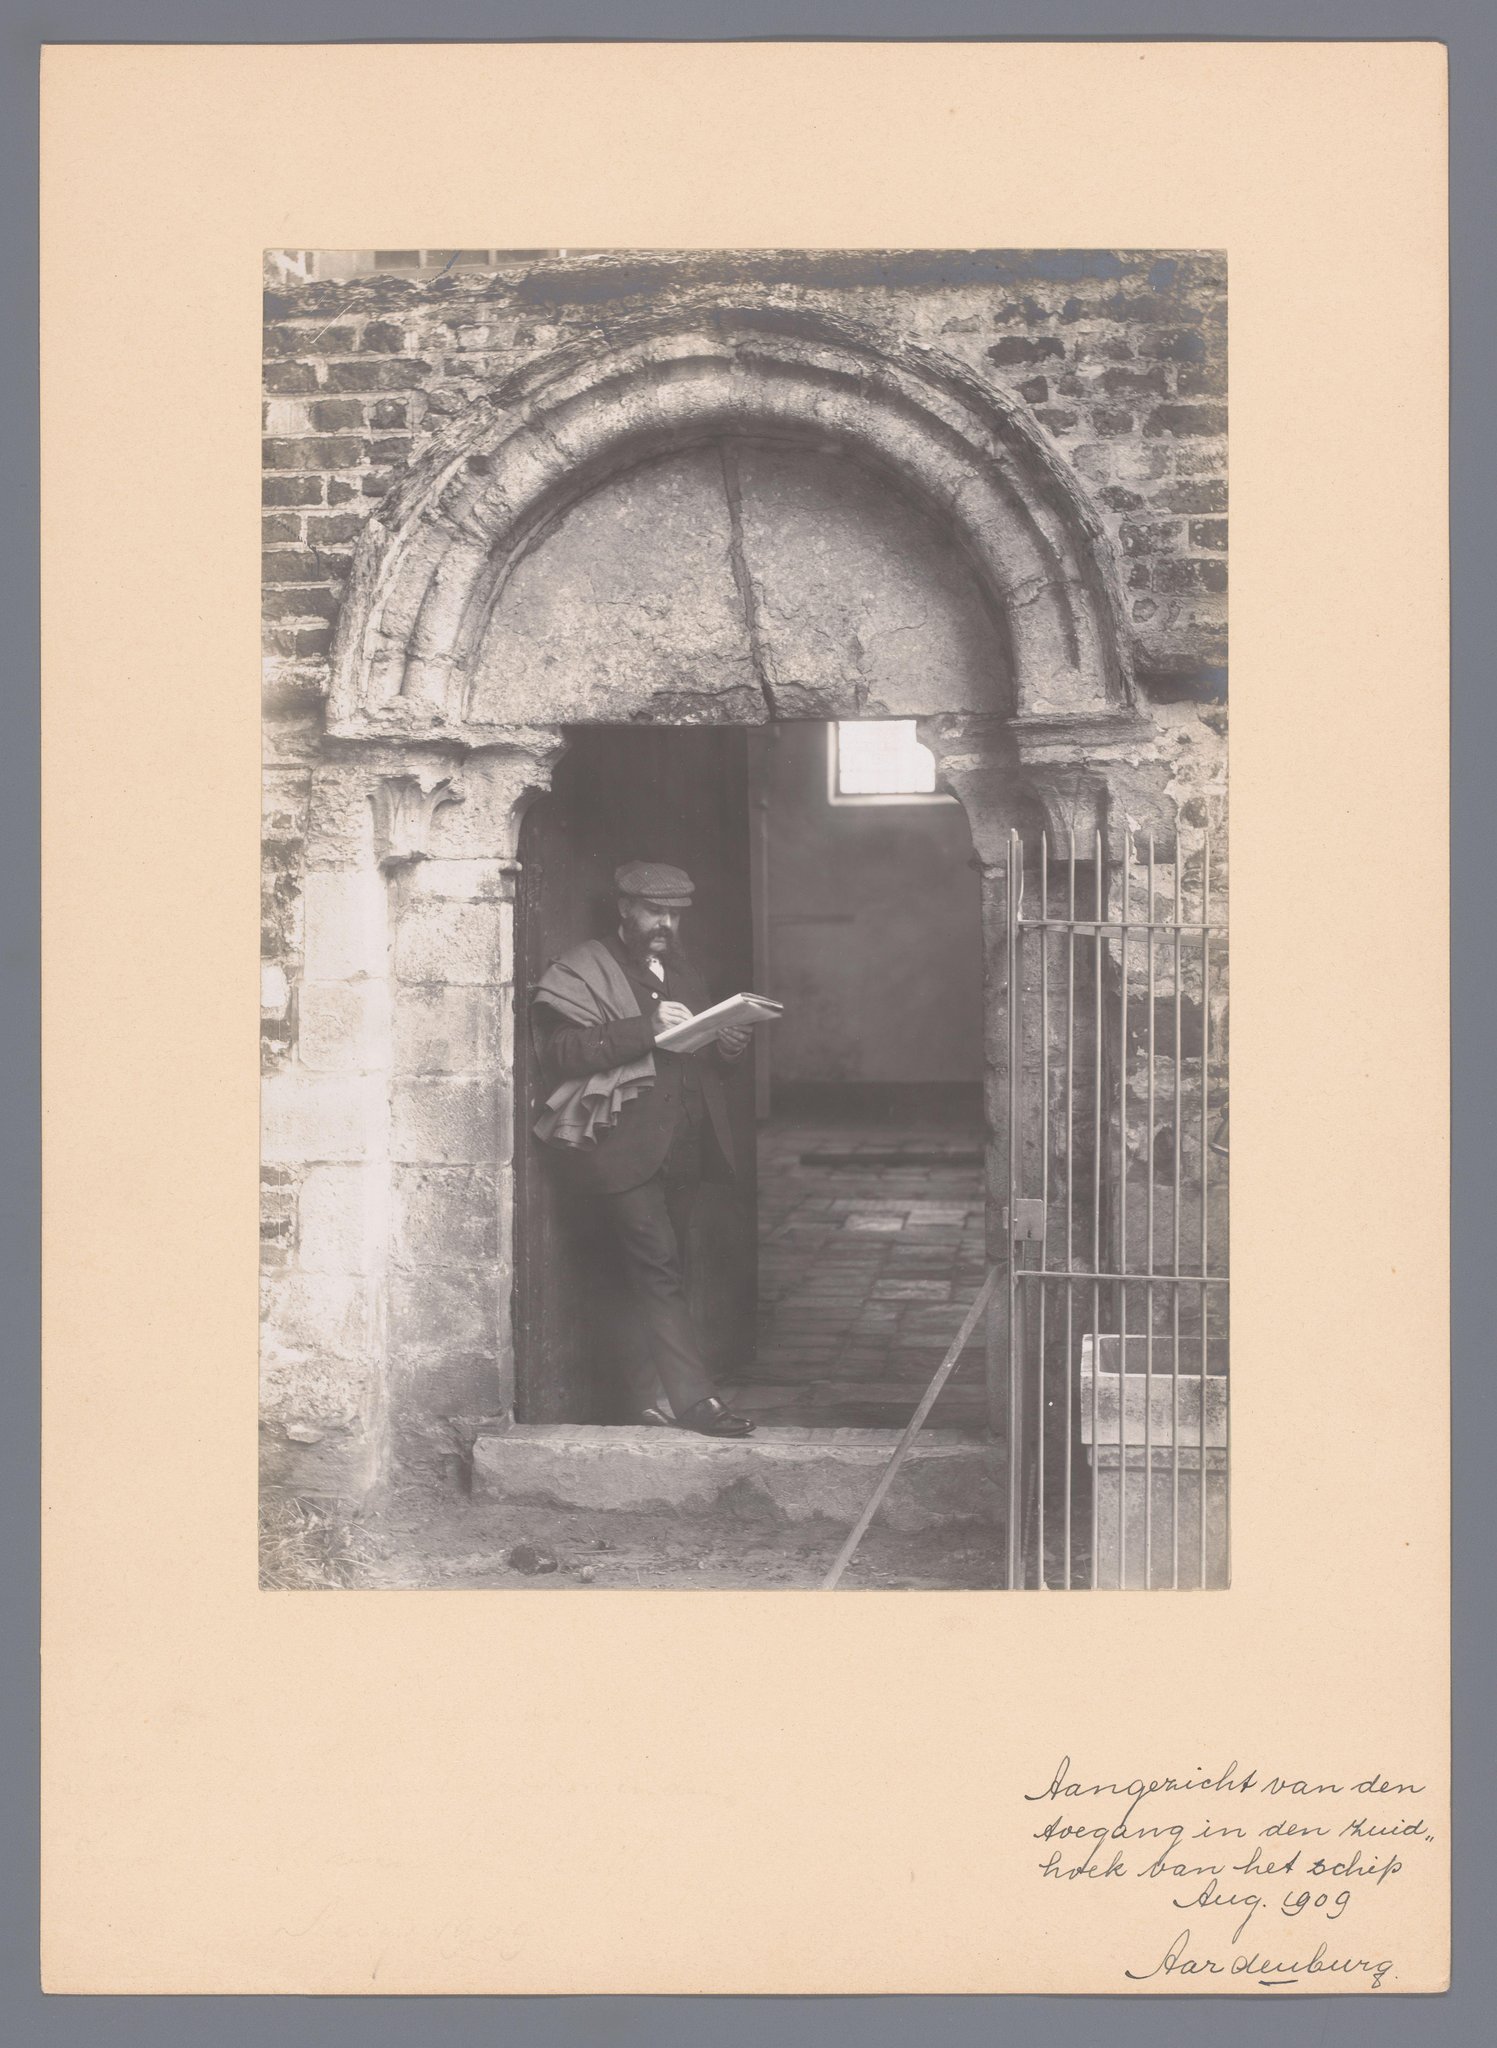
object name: photograph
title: A.J.M. Mulder staand in de toegang van het schip van Nederlands-Hervormde kerk in Aardenburg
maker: a.j.m. mulder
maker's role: engineer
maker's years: 1856-1936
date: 1909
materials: cardboard, photographic support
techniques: gelatin silver print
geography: aardenburg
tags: engineer, a.j.m. mulder, historical persons, portrait, self-portrait of photographer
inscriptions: annotation: ‘Aangezicht van den / toegang in den zuid= / hoek van het schip / Aug. 1909 / Aardenburg’, annotation: ‘V.L. v.d. Vinne’